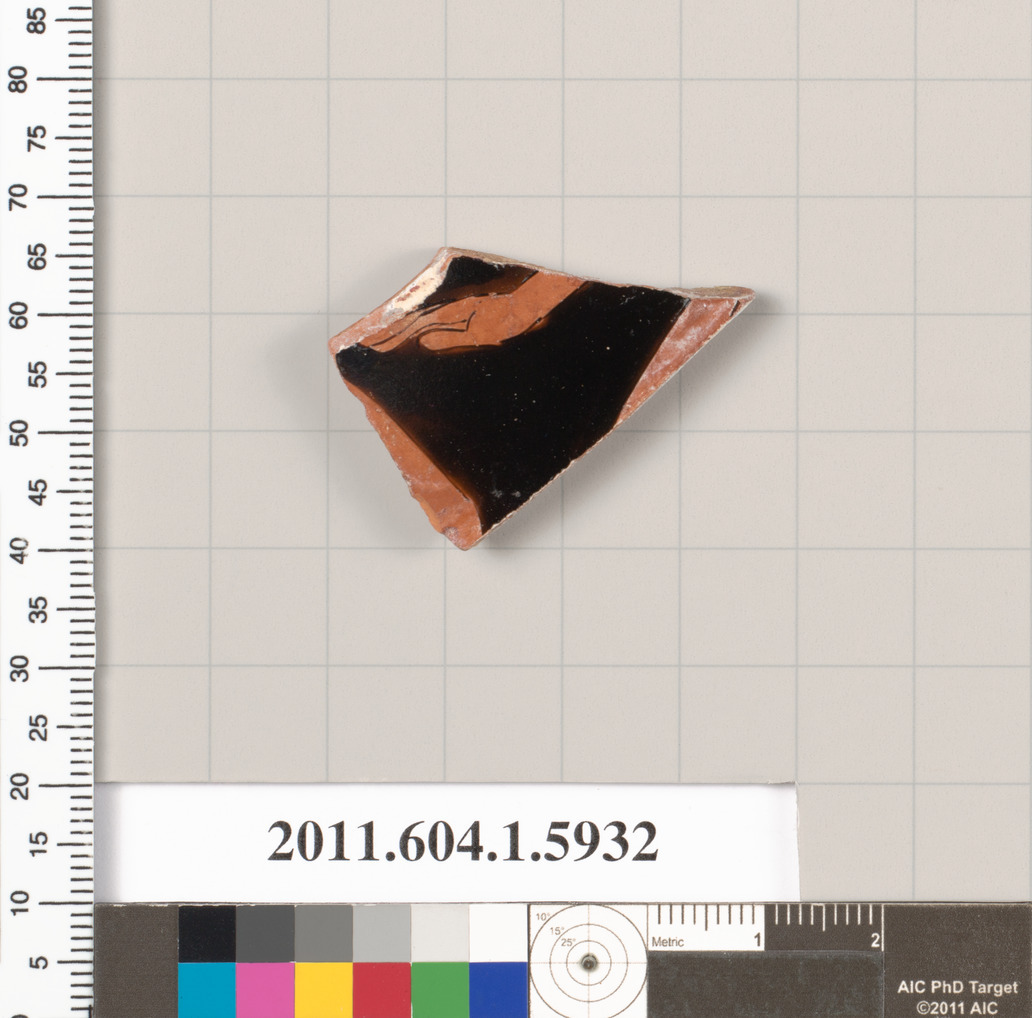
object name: kylix fragment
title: Terracotta fragment of a kylix (drinking cup)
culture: greek, attic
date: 520-510 BCE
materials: terracotta